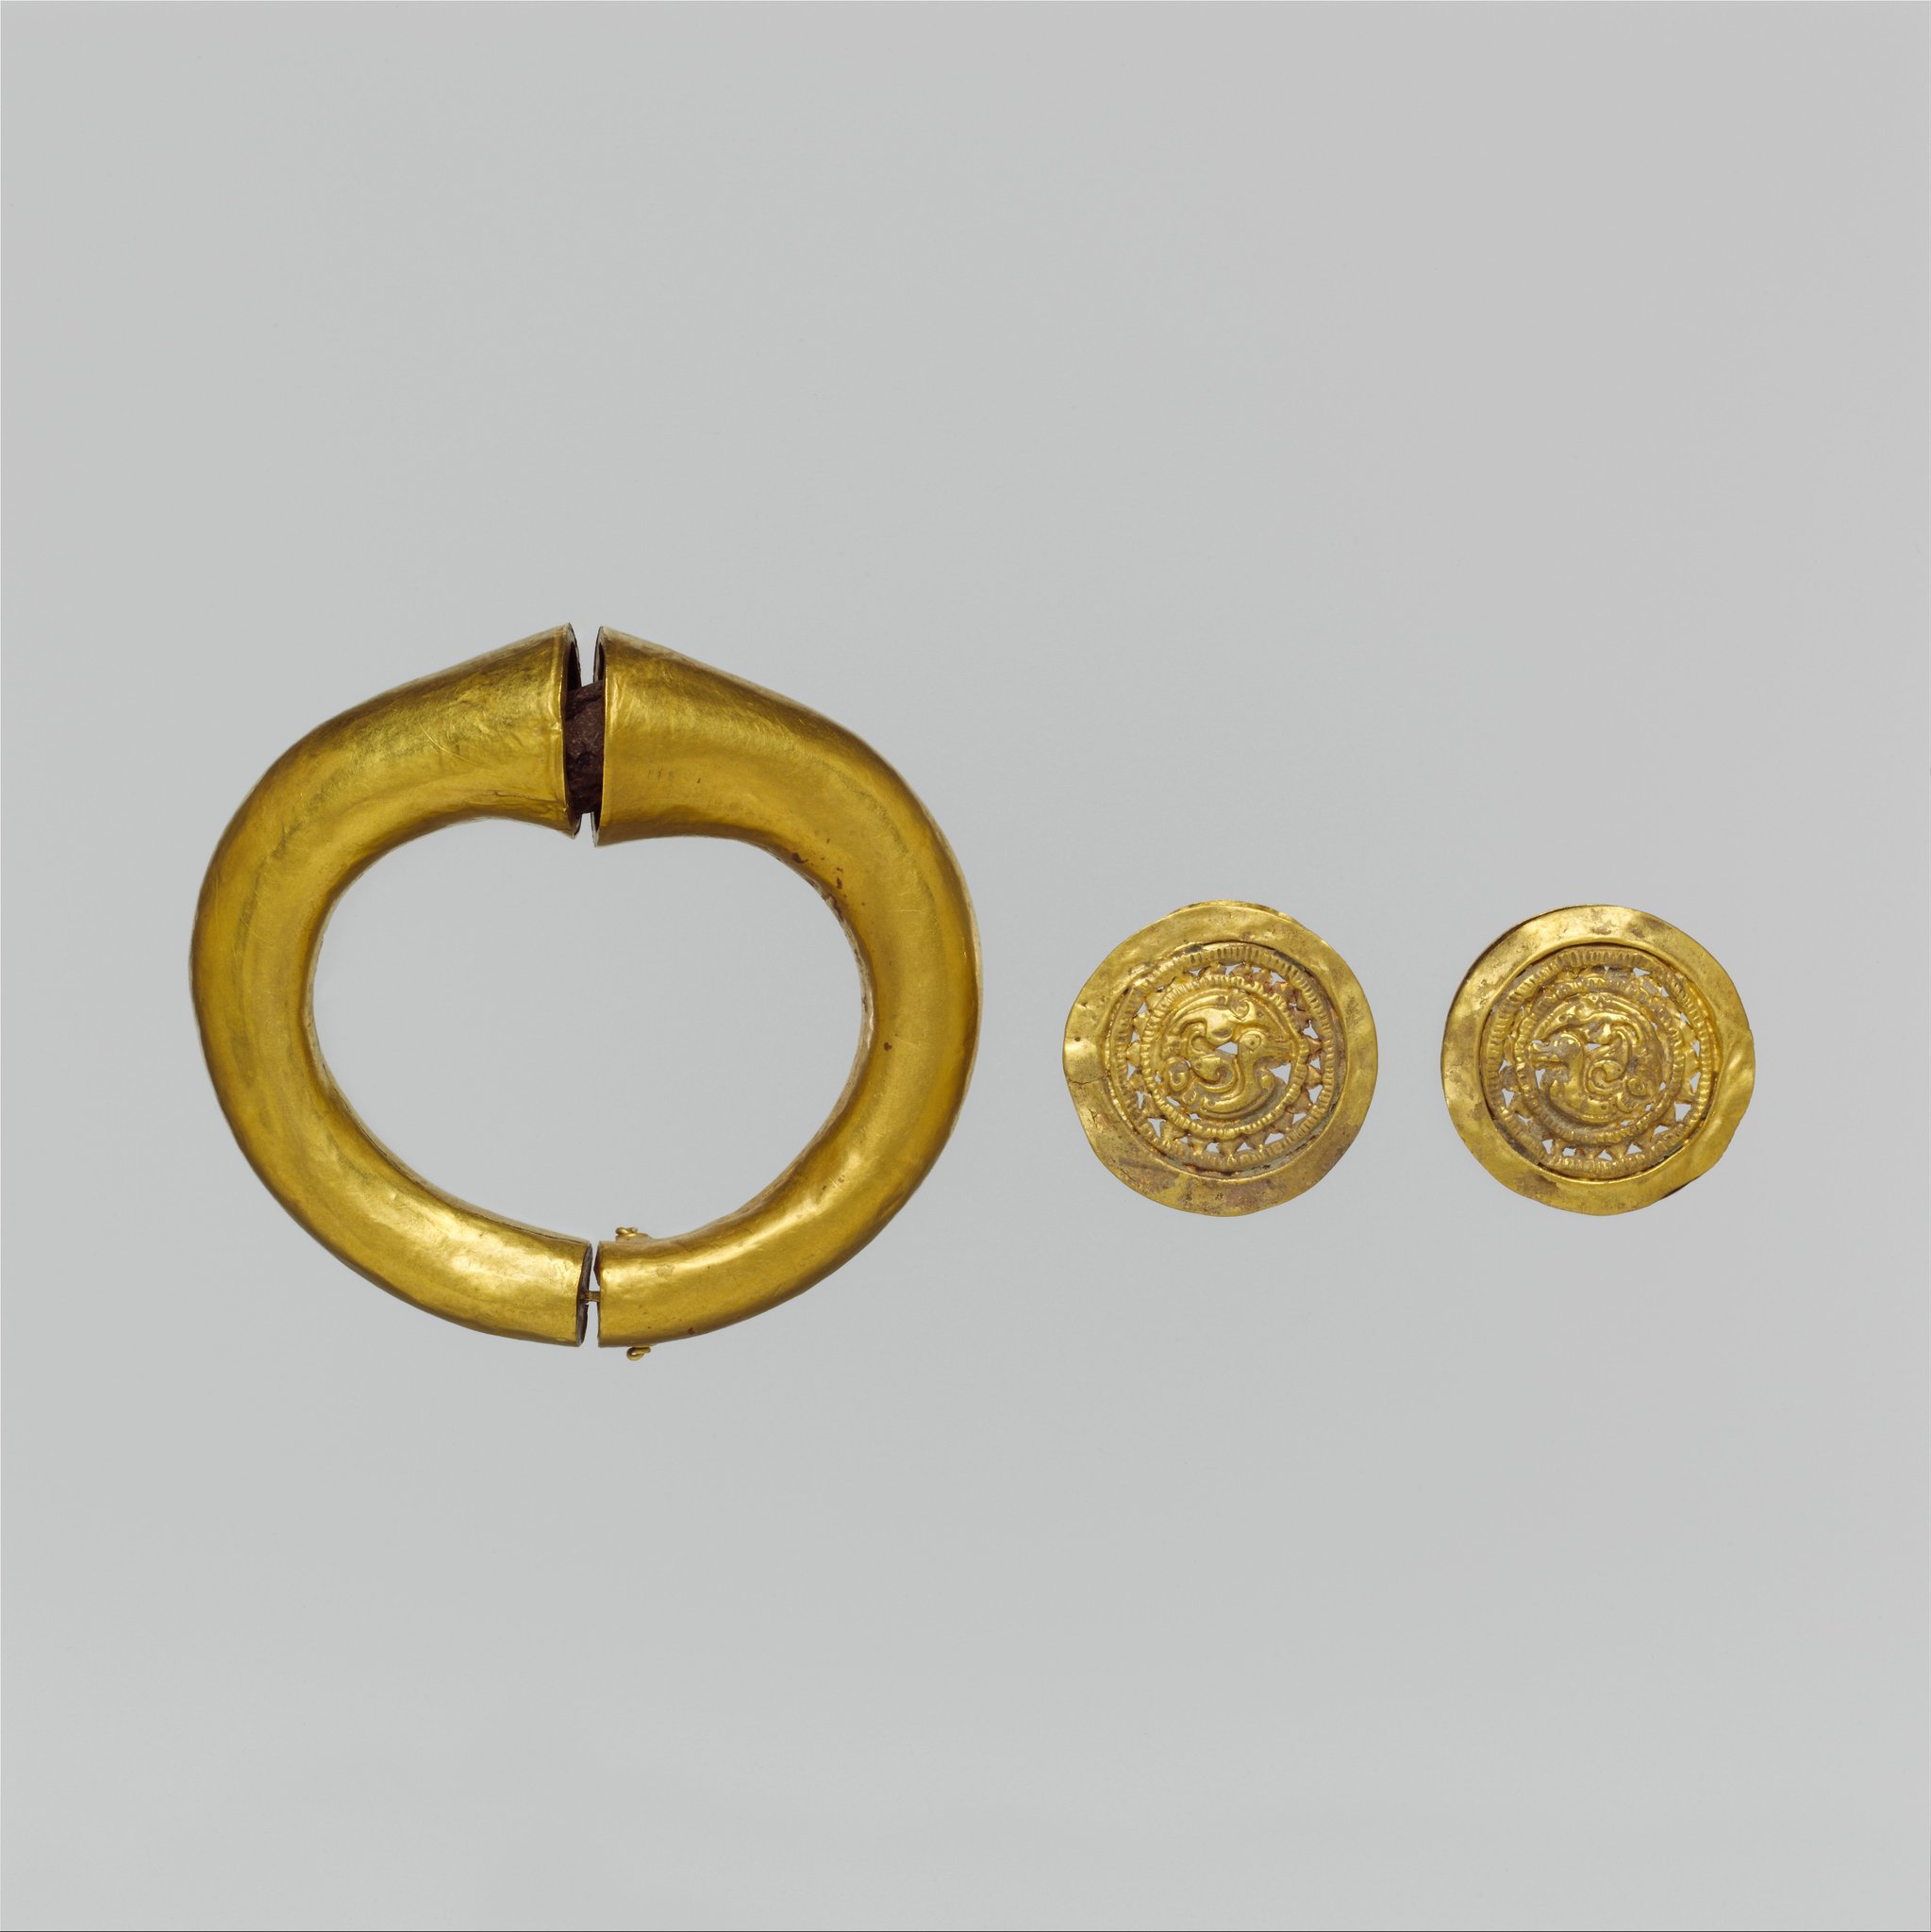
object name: ear plug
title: Pair of Ear Plugs with Hamsas (Wild Geese)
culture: gandhara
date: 1-100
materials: gold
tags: gandhara